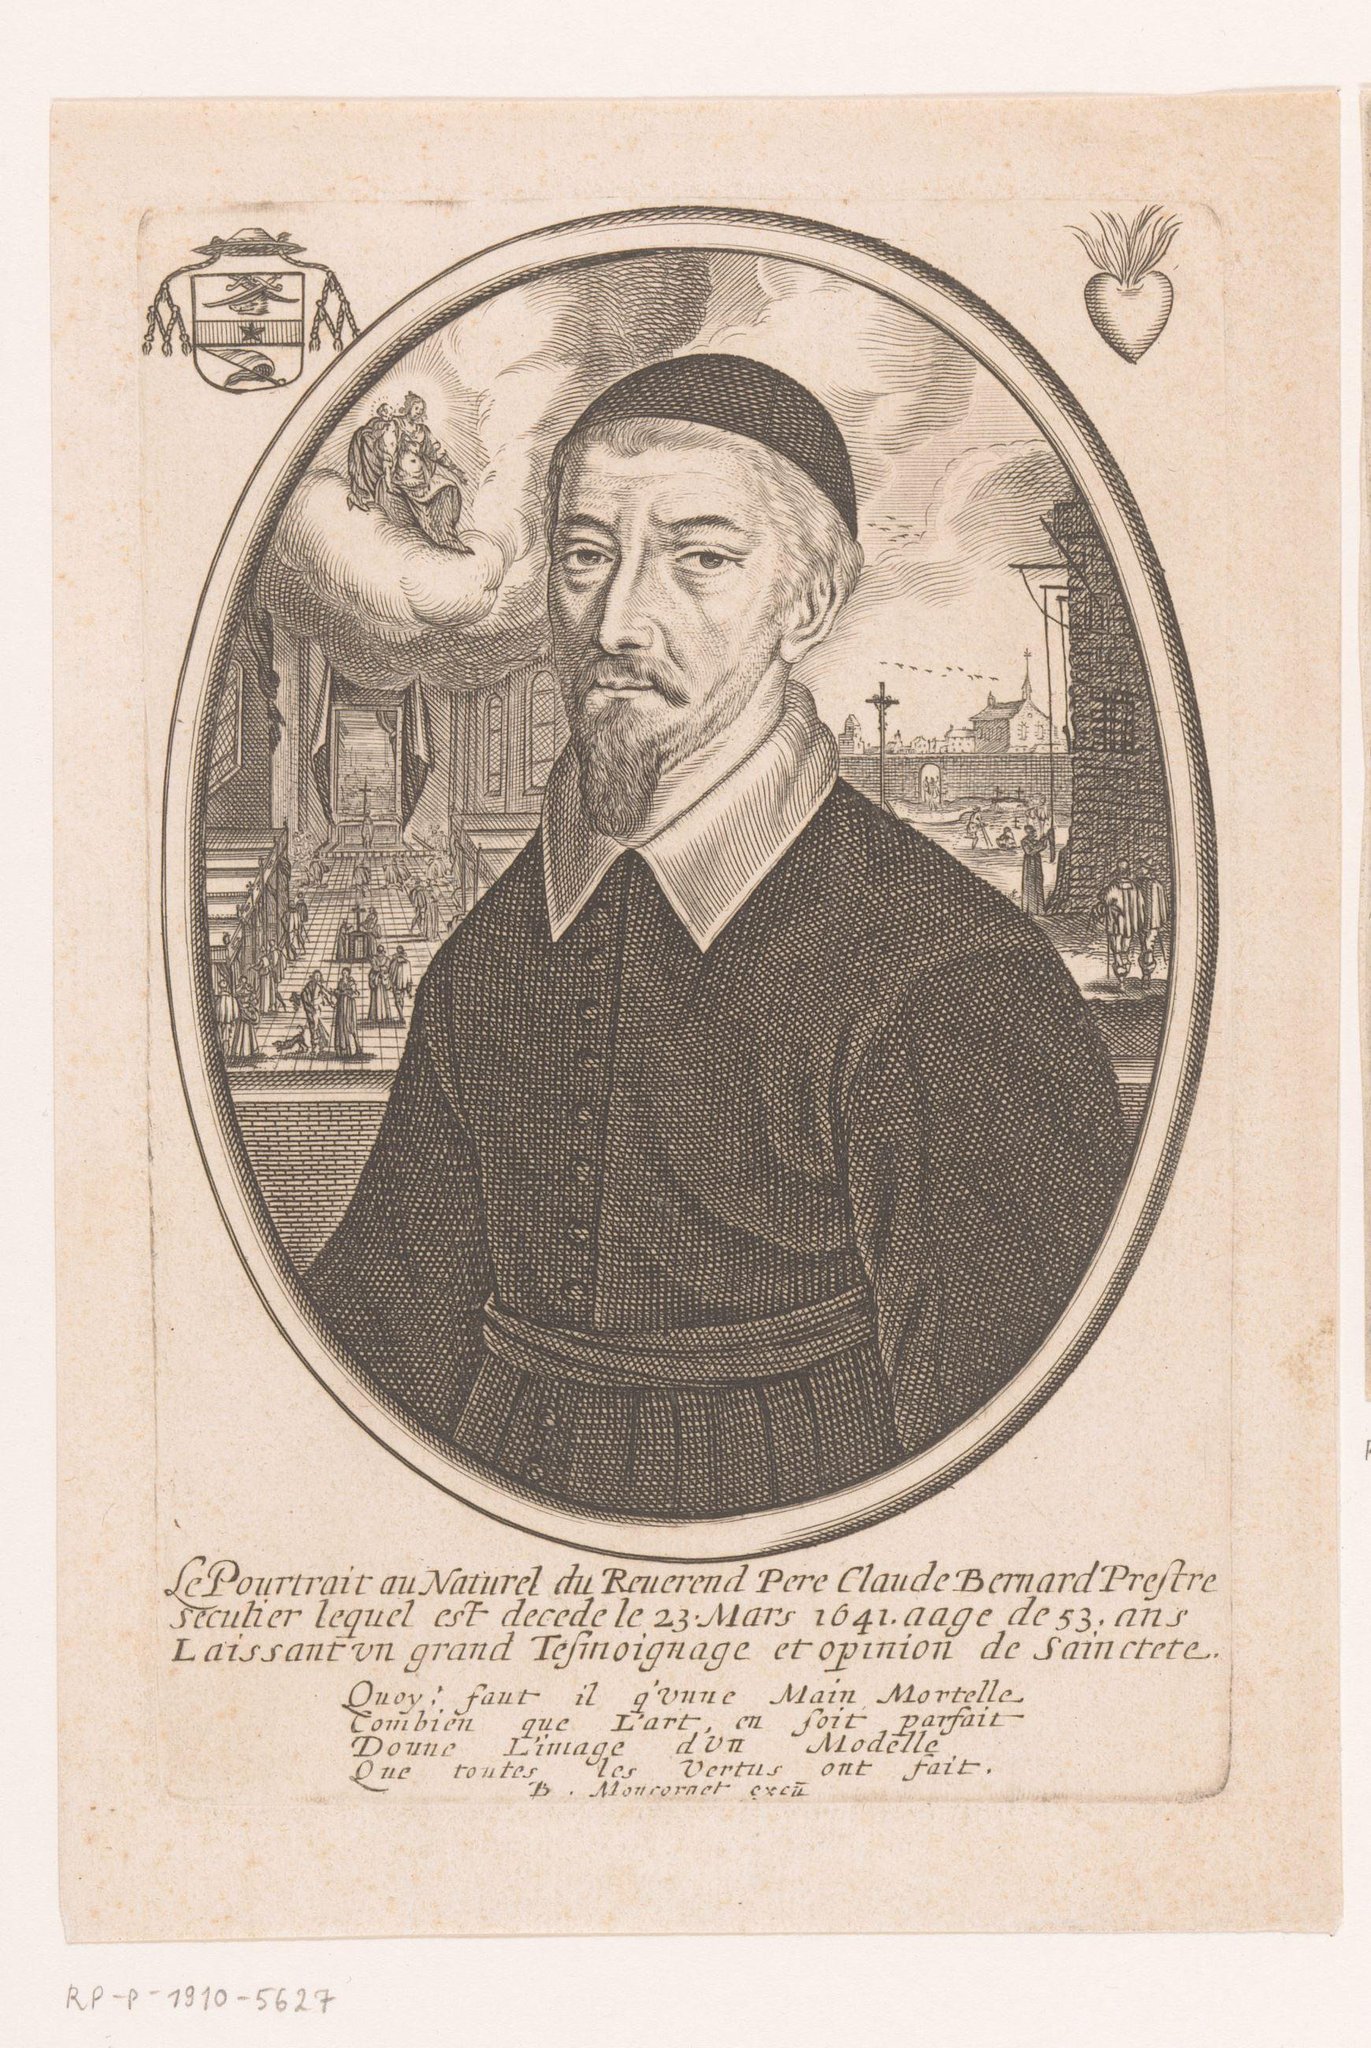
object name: print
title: Portret van Claude Bernard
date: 1641-1668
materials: paper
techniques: engraving, etching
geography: paris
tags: paris, priest, priest (roman catholic), historical persons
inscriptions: collector's mark: Lugt 2228